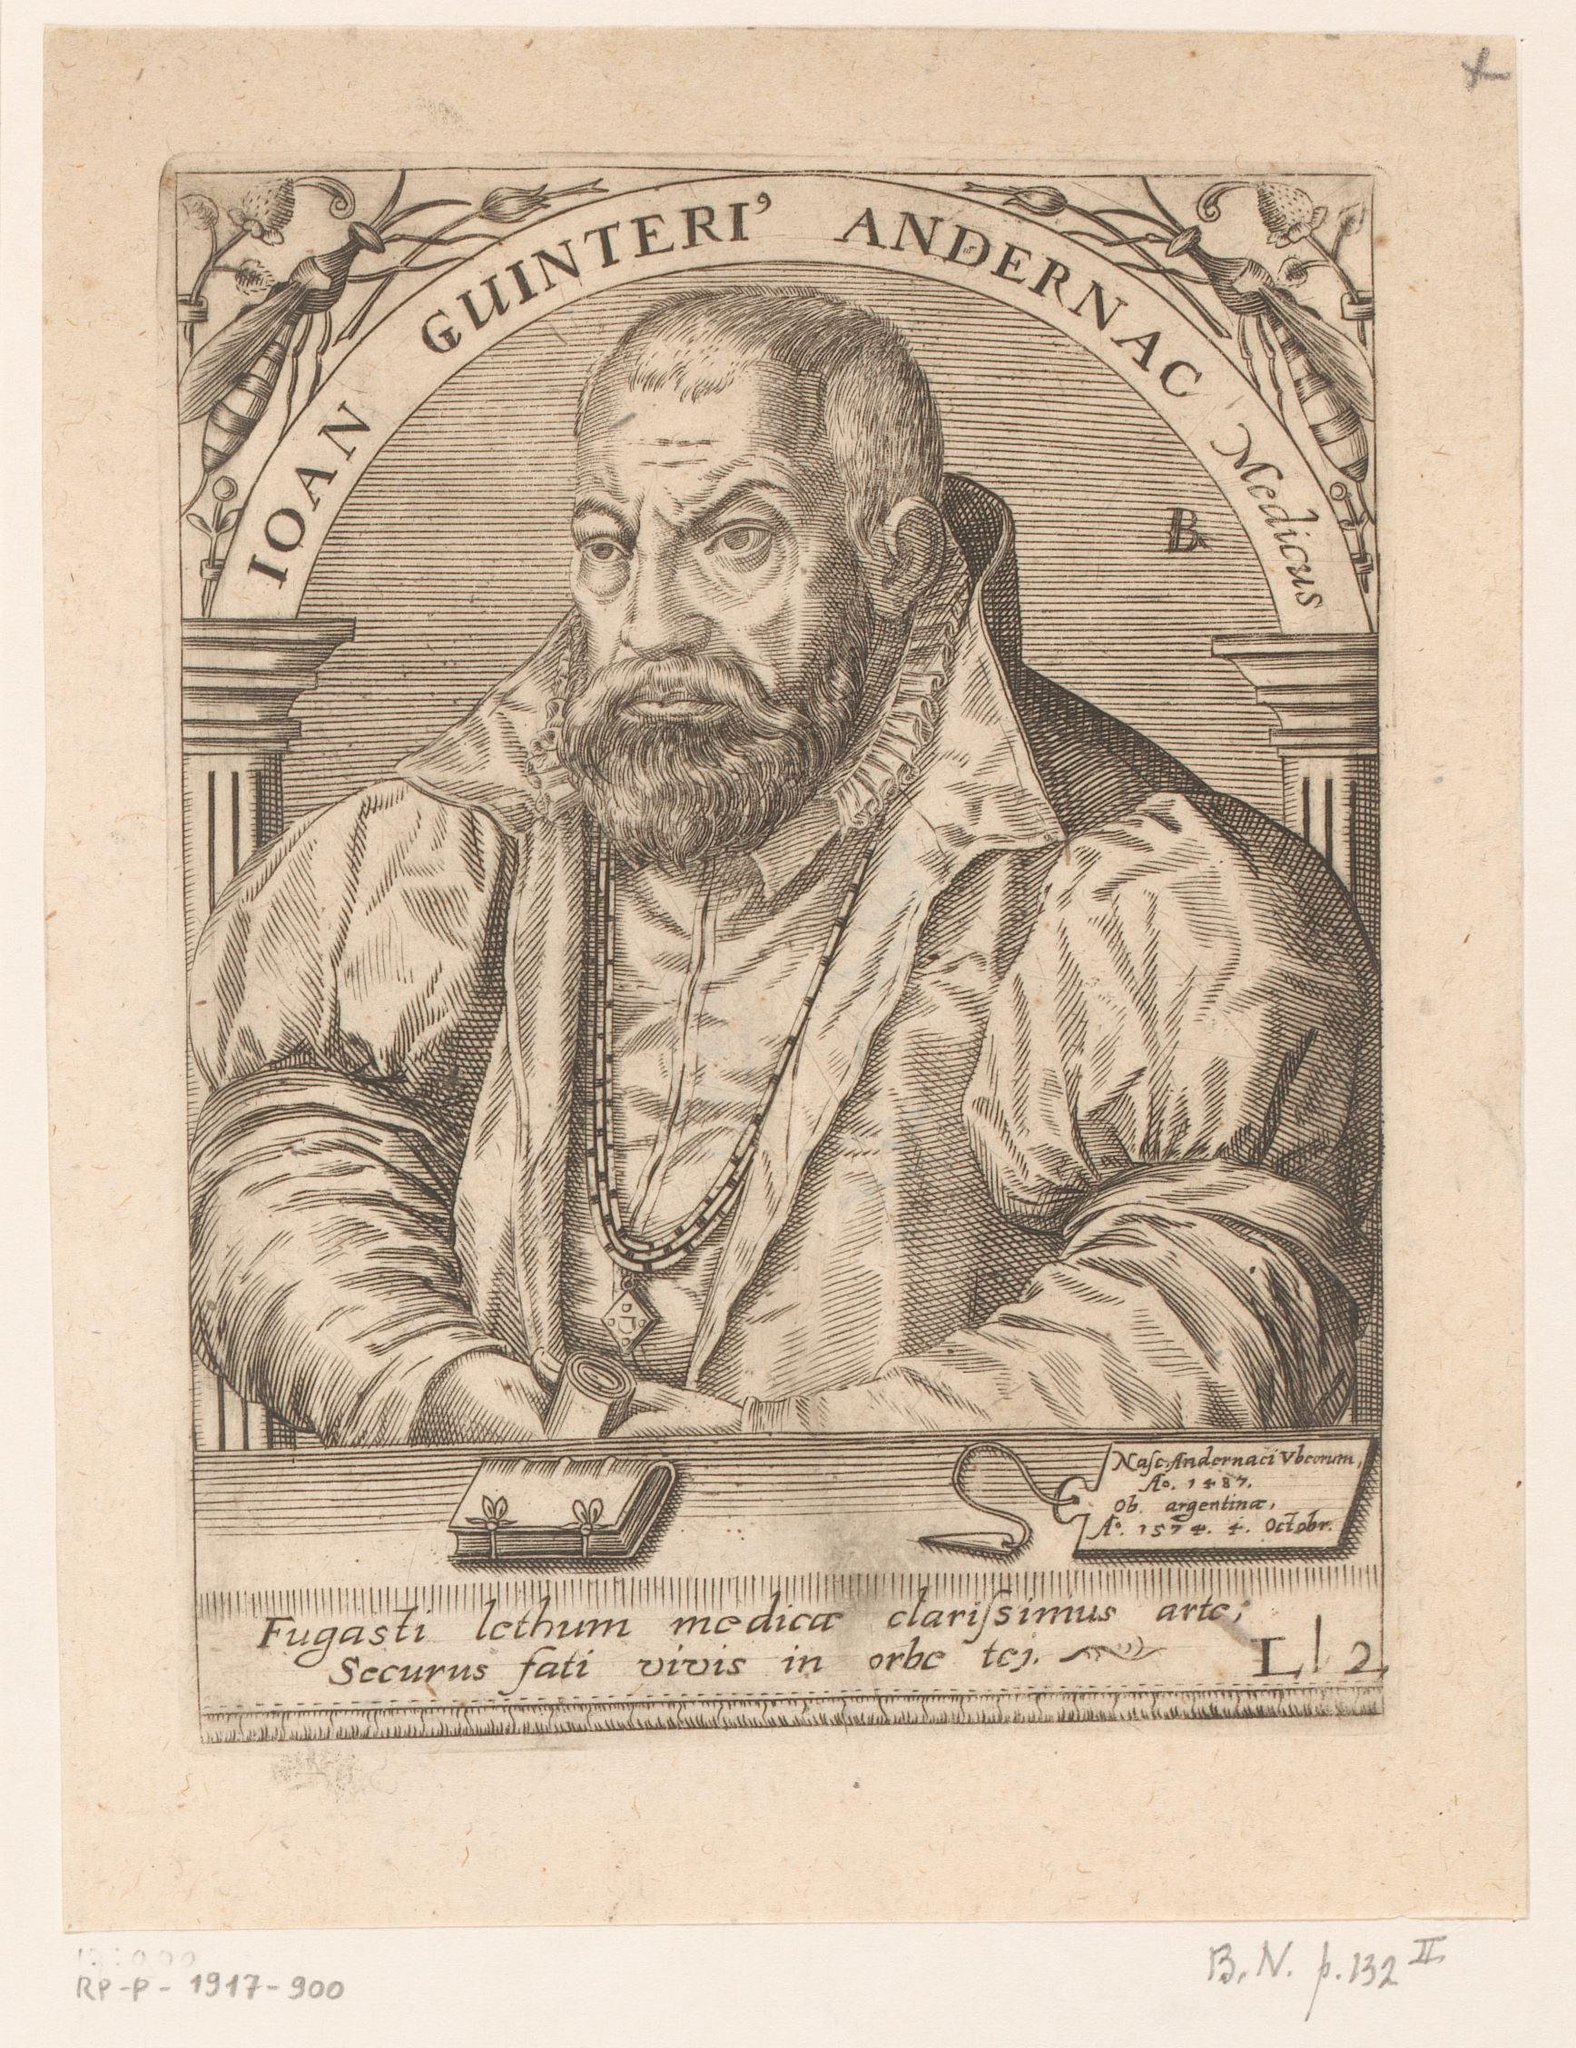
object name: print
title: Serie portretten van vijftiende- en zestiende-eeuwse geleerden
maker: robert boissard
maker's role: print maker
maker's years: 1570-1611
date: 1597-1599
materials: paper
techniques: engraving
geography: france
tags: historical persons, insects: wasp, book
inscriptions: collector's mark: Lugt 2228